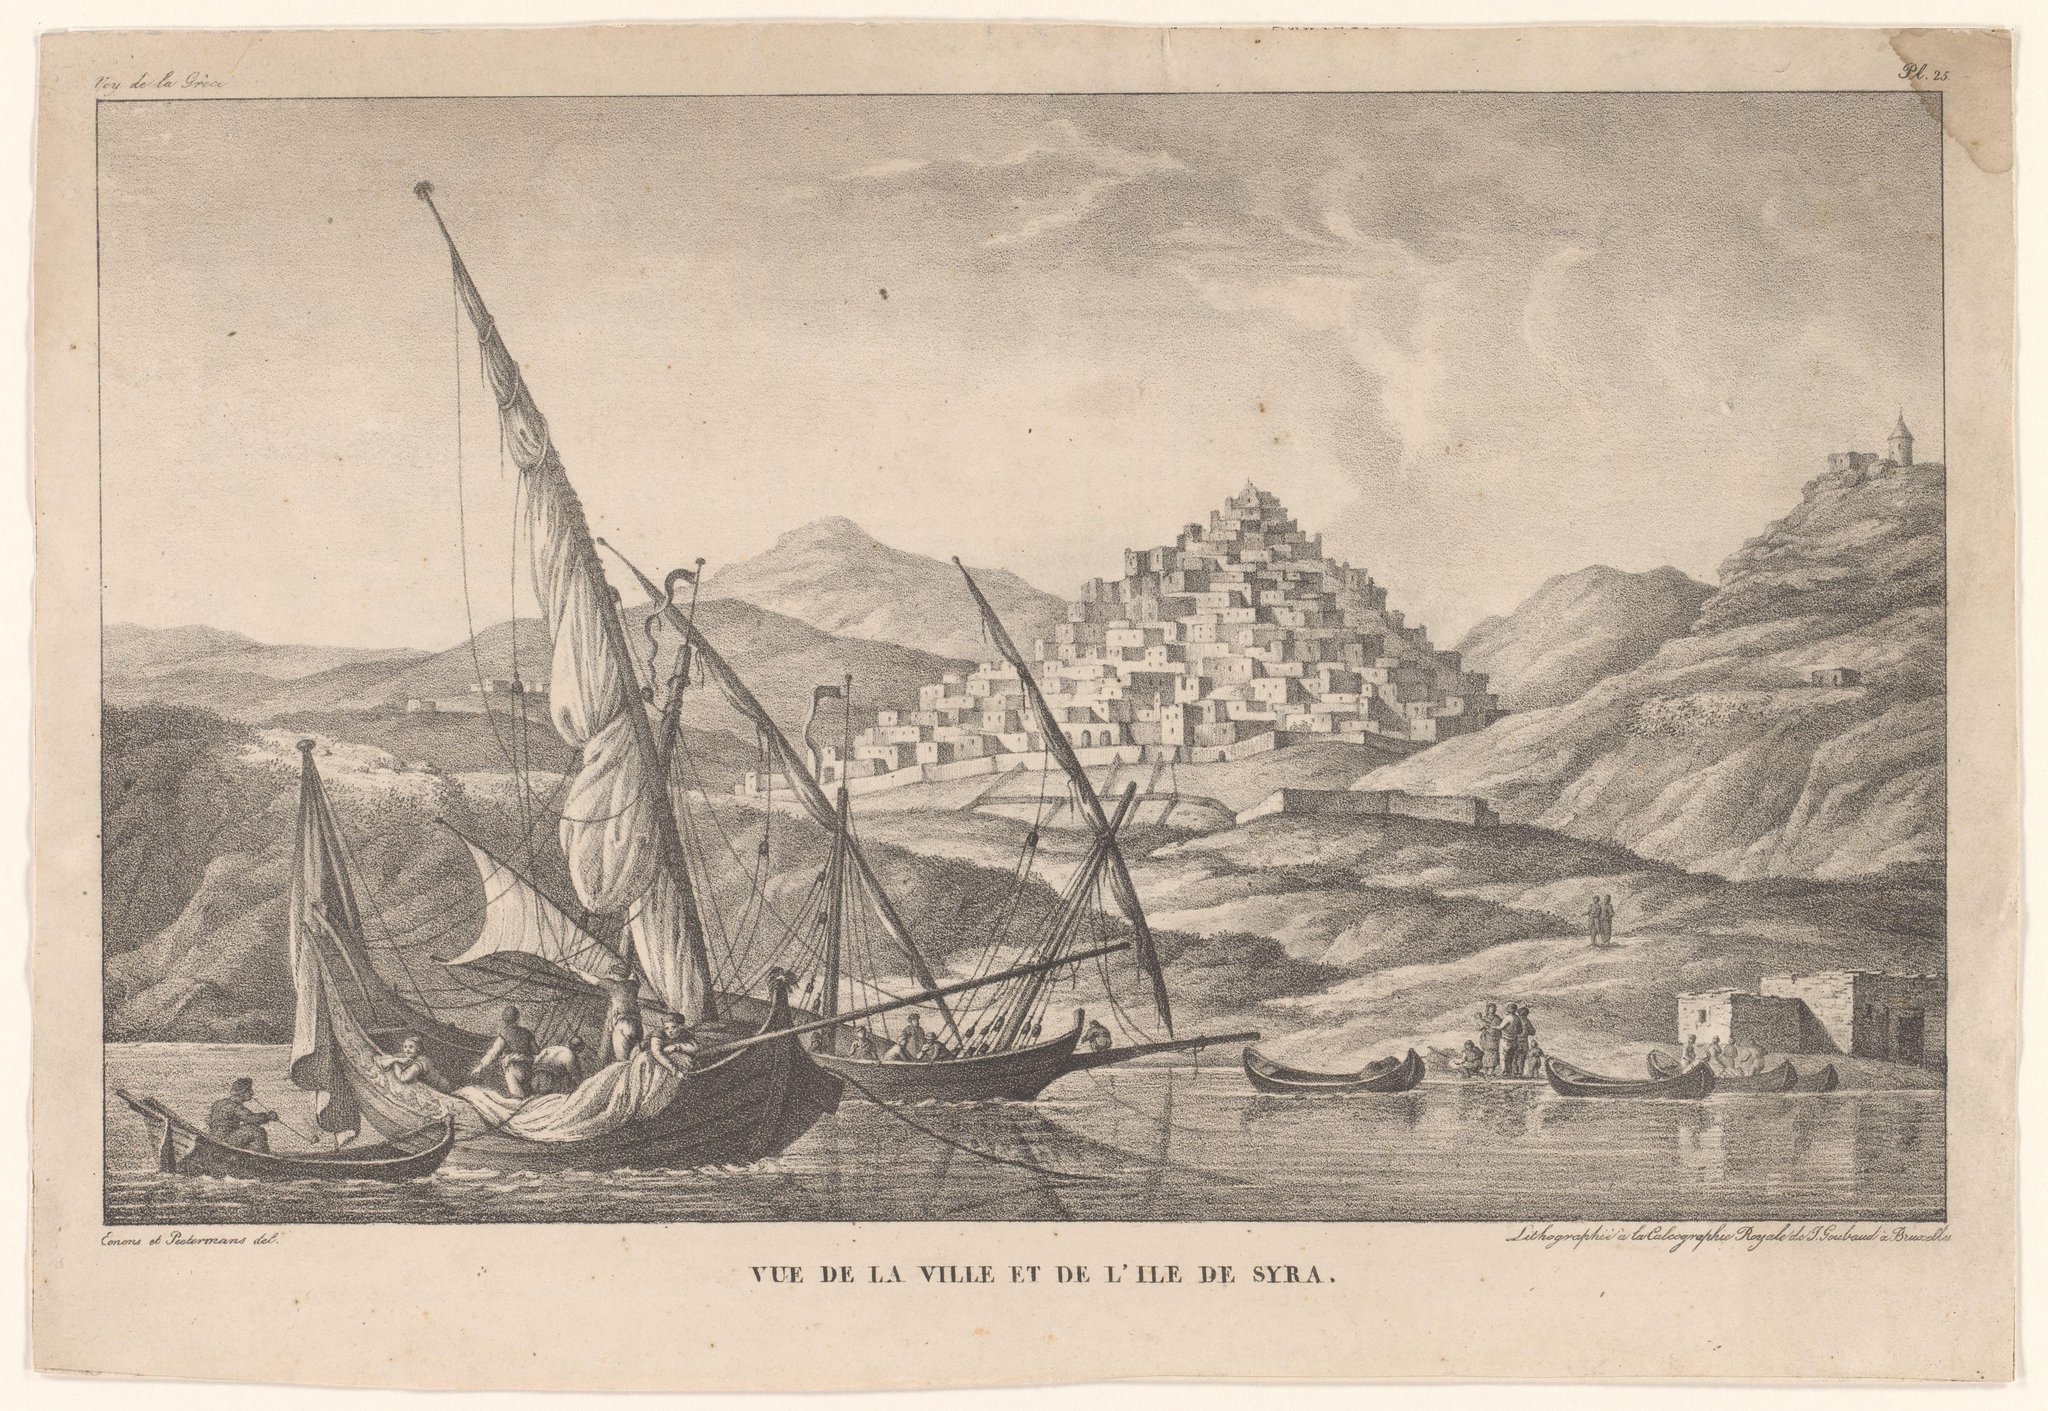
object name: print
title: Gezicht op het eiland Syros met zeilboten in het water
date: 1822-1825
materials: paper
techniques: lithograph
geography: brussels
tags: island, landscapes with waters, waterscapes, seascapes (in the temperate zone), traffic on the water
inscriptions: collector's mark: Lugt 2228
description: Prent waarschijnlijk verschenen in: Choiseul-Gouffier, Marie-Gabriel-Auguste-Florent. Voyage pittoresque de la Grèce. Parijs: s.n., 1822-1825.